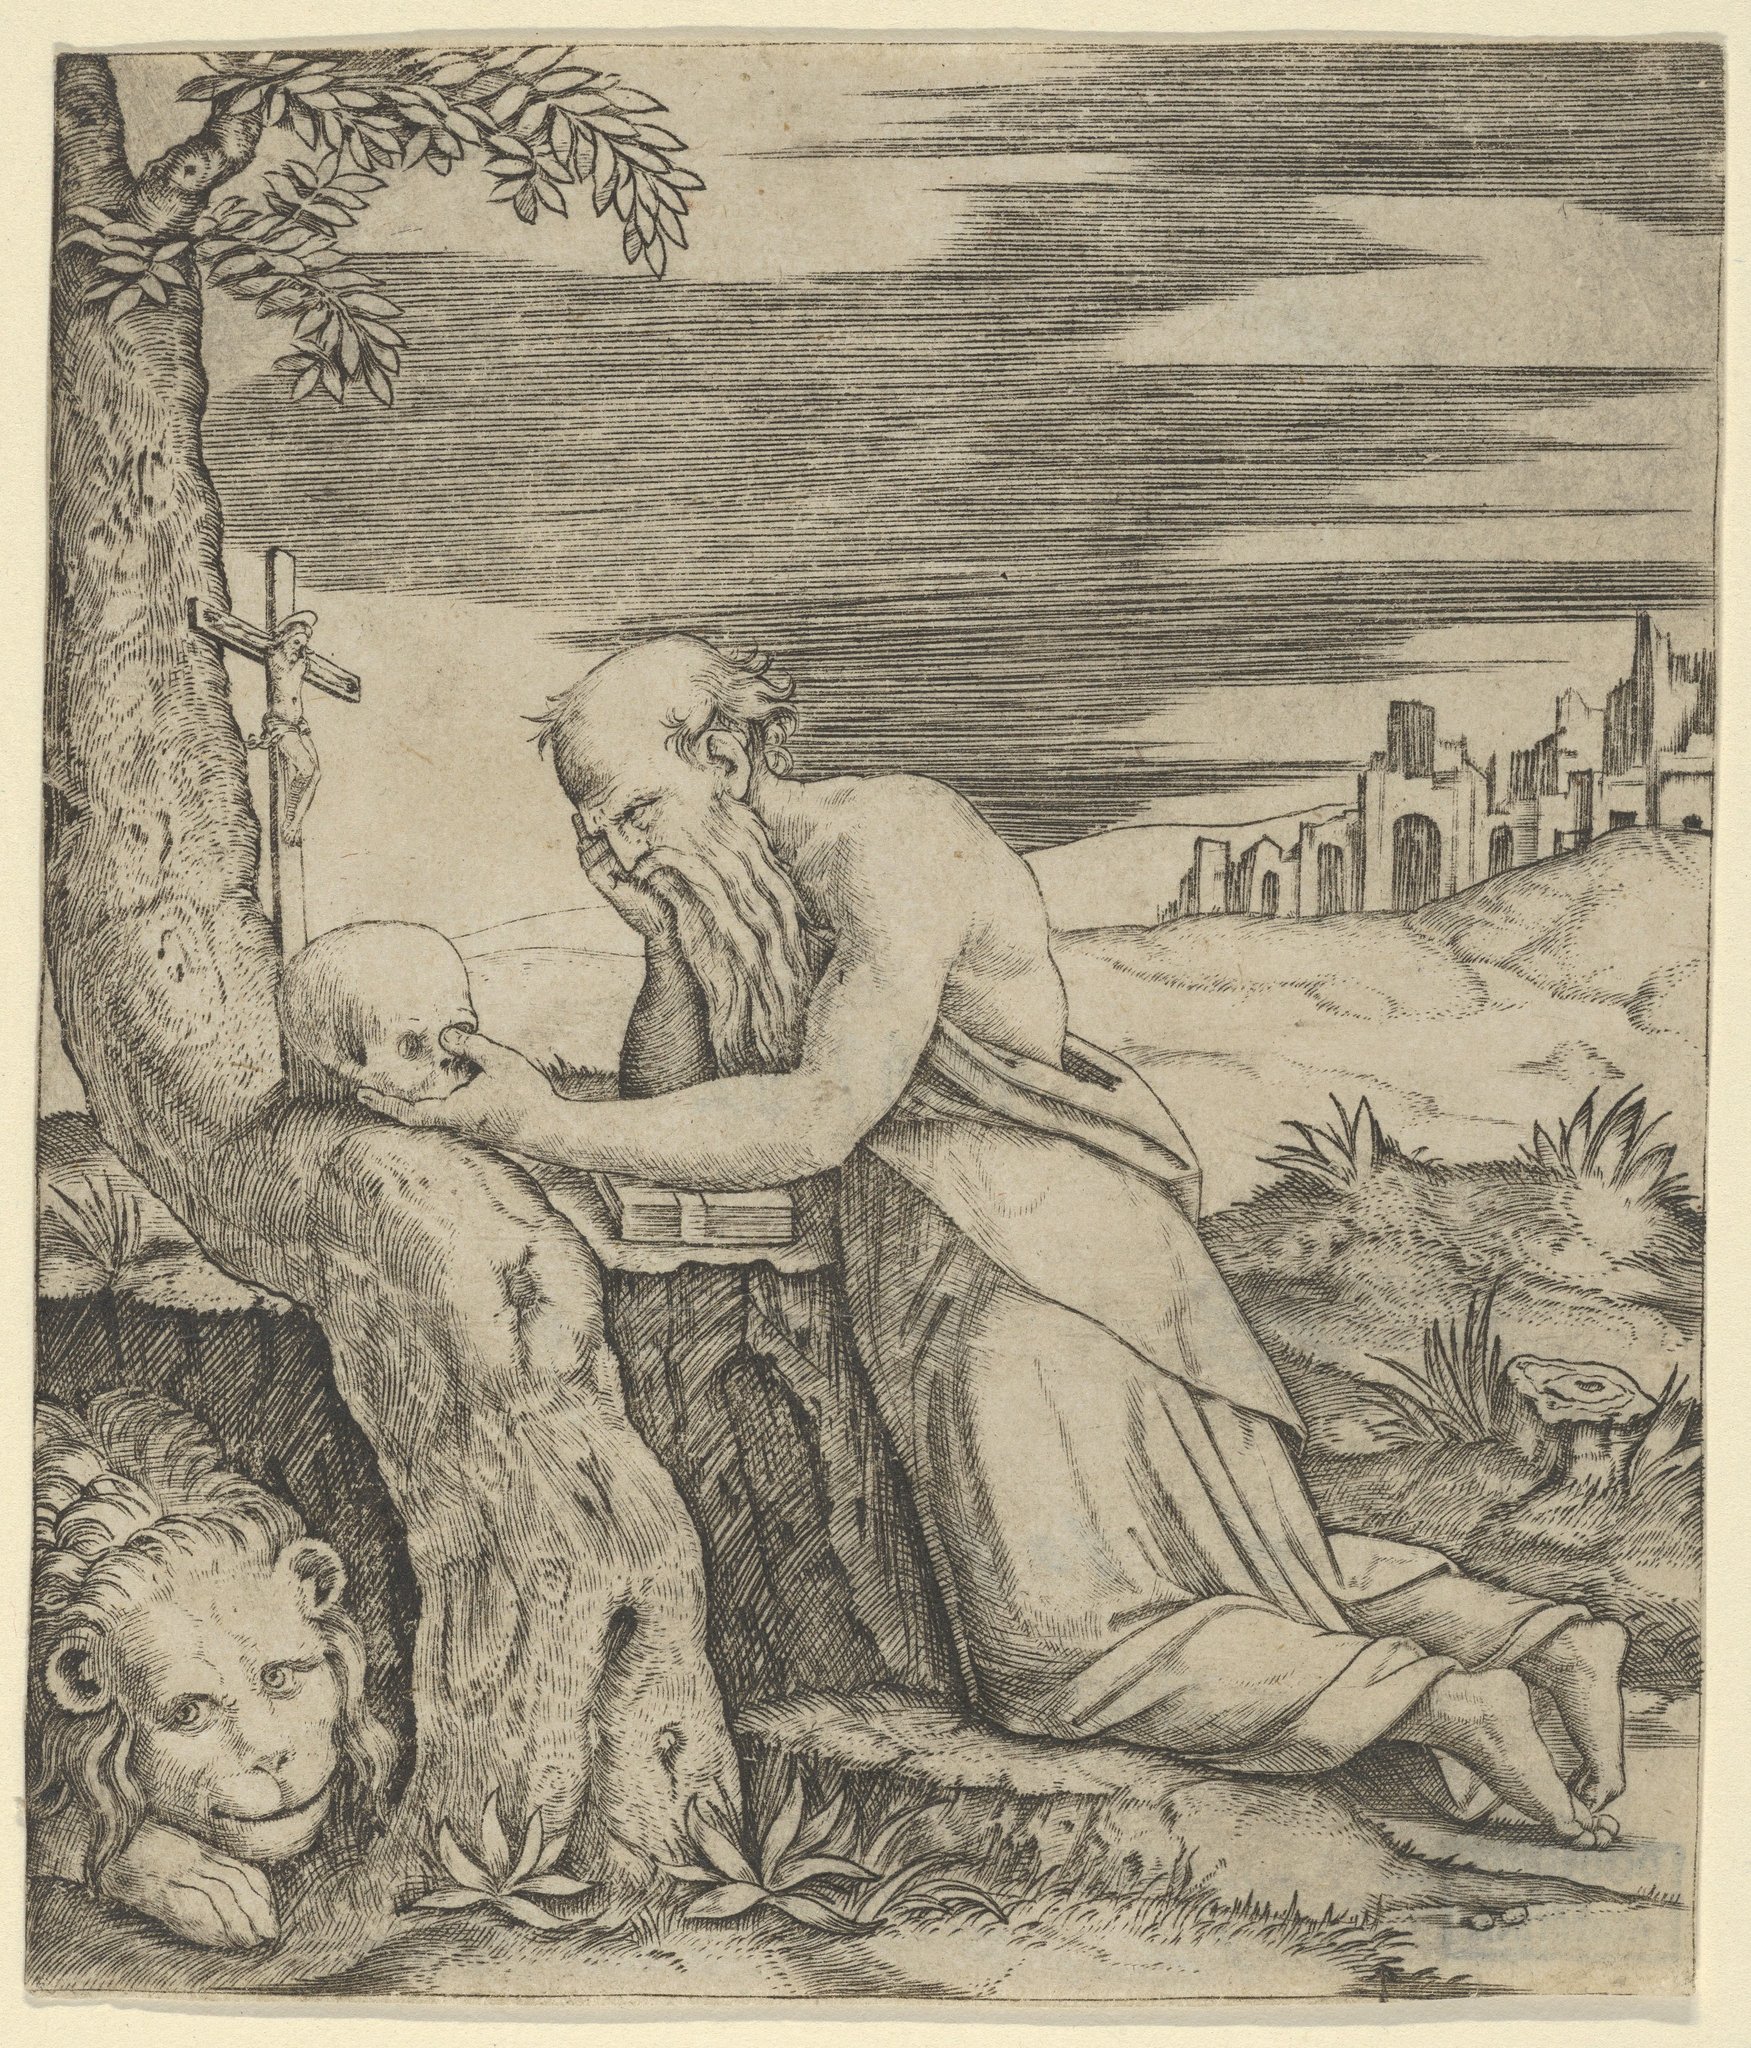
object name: print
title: St Jerome kneeling before a crucifix, a skull in his left hand, a lion laying at the left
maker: marcantonio raimondi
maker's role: artist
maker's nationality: italian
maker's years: 1475-1534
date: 1500-1527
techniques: engraving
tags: skulls,contemplation,lions,saint jerome,crucifixion